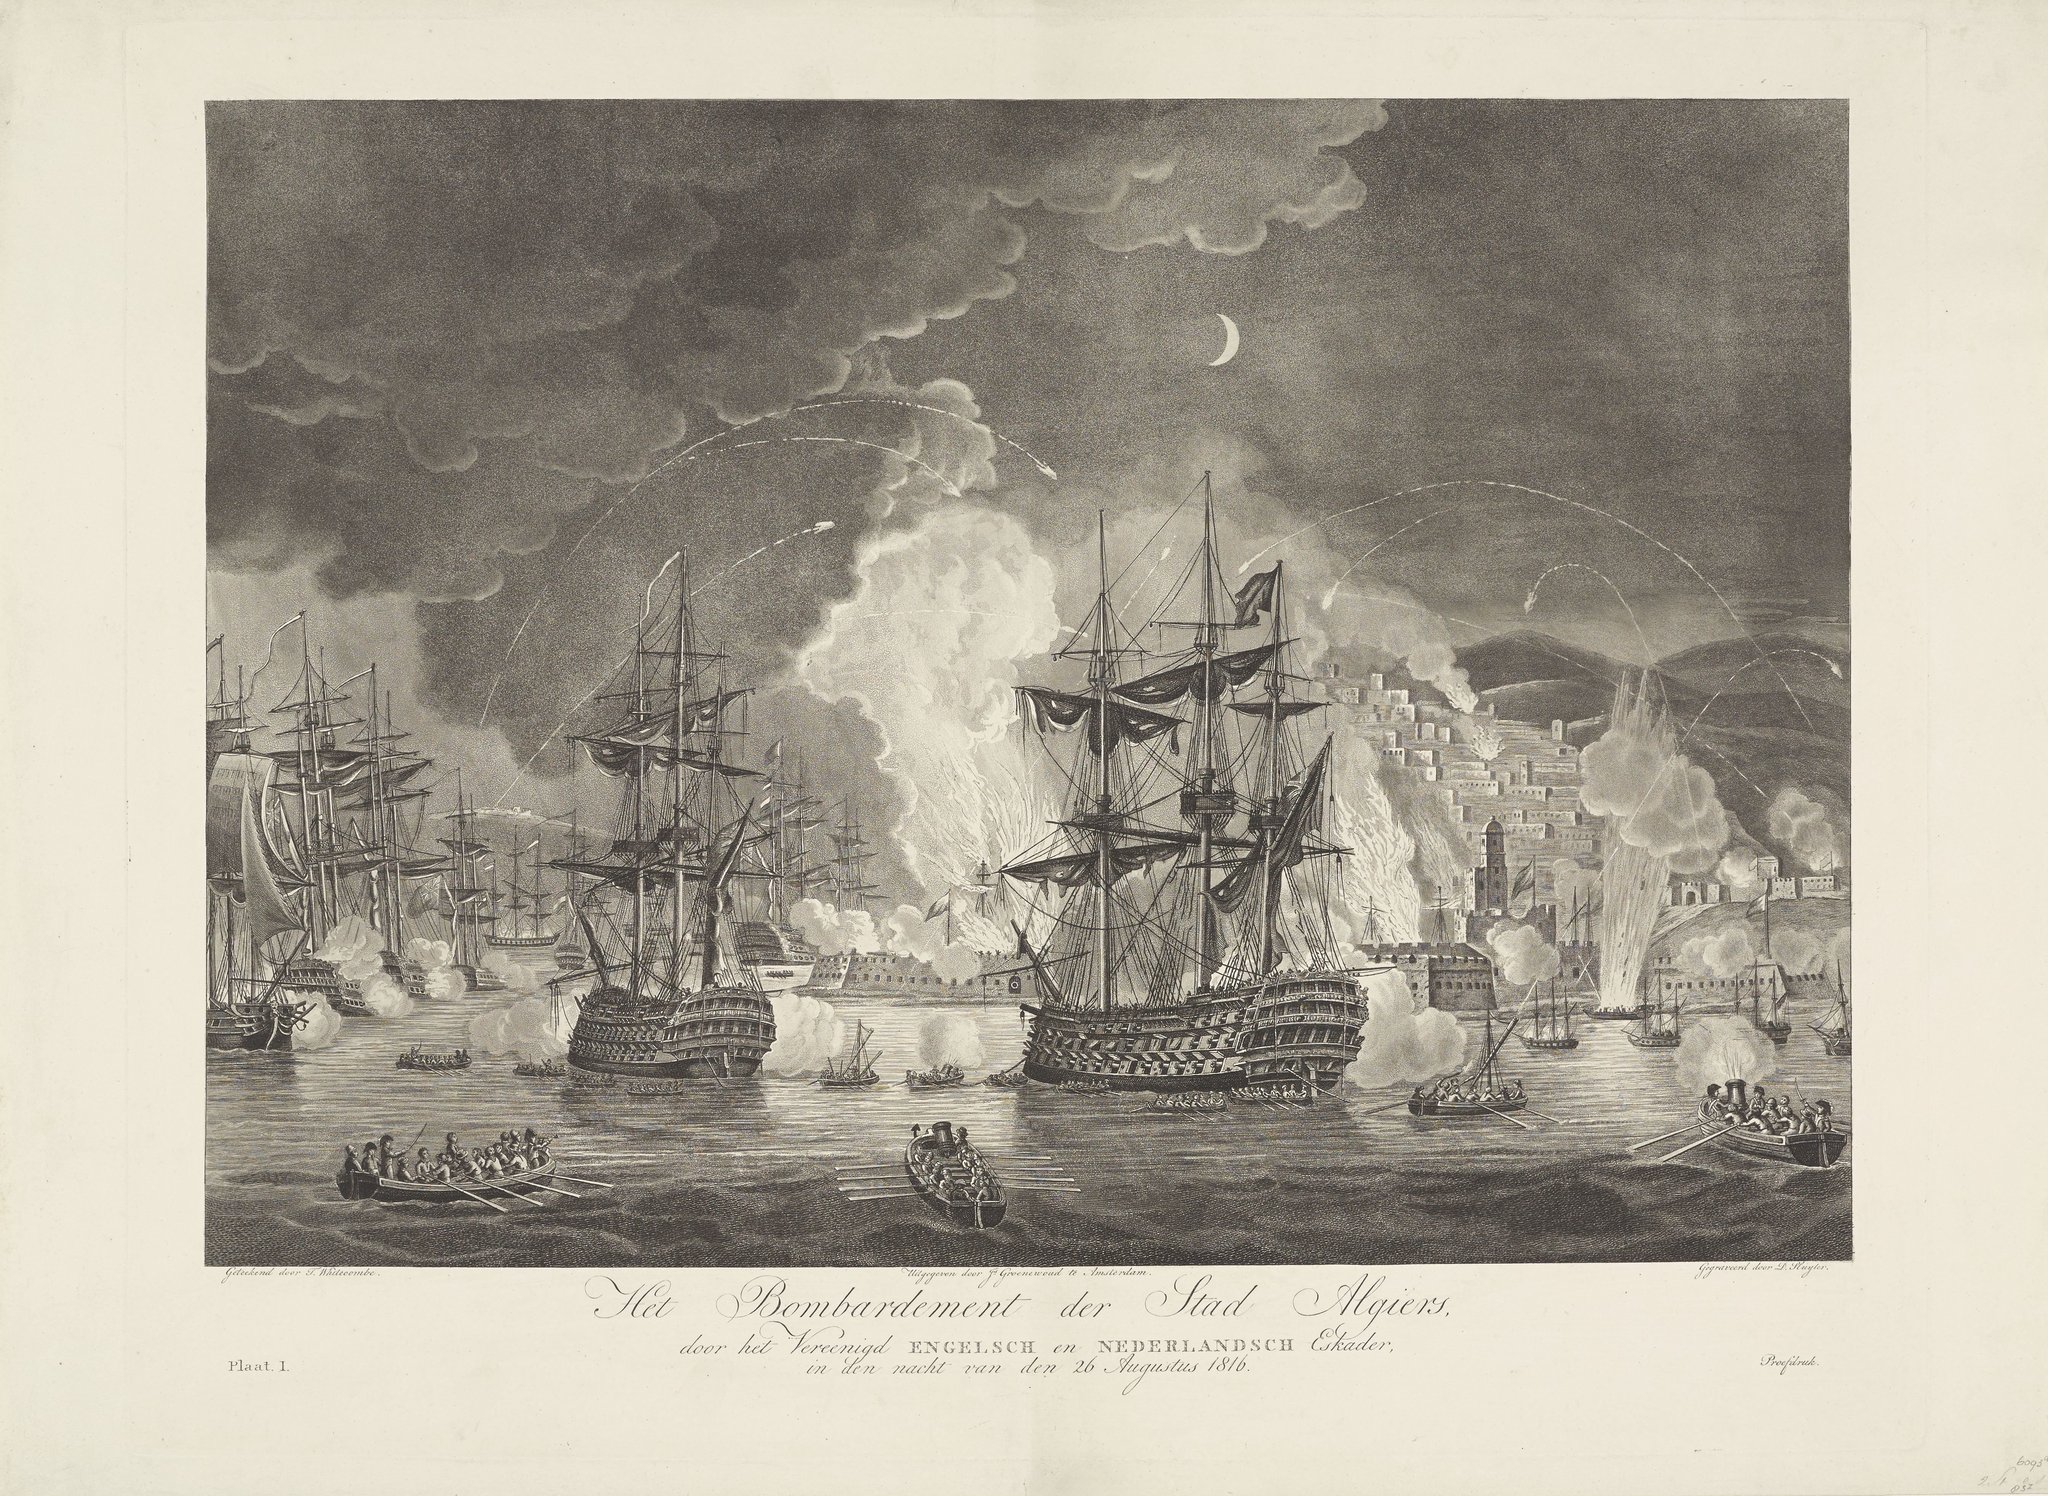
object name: print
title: Het Bombardement der Stad Algiers, door het Vereenigd Engelsch en Nederlandsch Eskader, in den nacht van den 26 Augustus 1816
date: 1816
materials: paper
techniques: aquatint, engraving, etching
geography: amsterdam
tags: nijmegen, brussels, navy (+ sailing-ships), bombardment (+ sailing-ships), bombardment ~ siege (+ sailing-ships)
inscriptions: collector's mark: Lugt 2228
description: Bombardement van de stad Algiers door een verenigd Brits en Nederlands eskader onder commando van Lord Exmouth en Baron van der Capelle, in de nacht van 26 op 27 augustus 1816. Centraal op de voorgrond twee grote Britse schepen, links meer naar achteren zijn enkele Nederlands schepen herkenbaar. Tussen de grote schepen varen verschillende sloepen. Het fort van Algiers staat in brand. Zie ook de pendant.